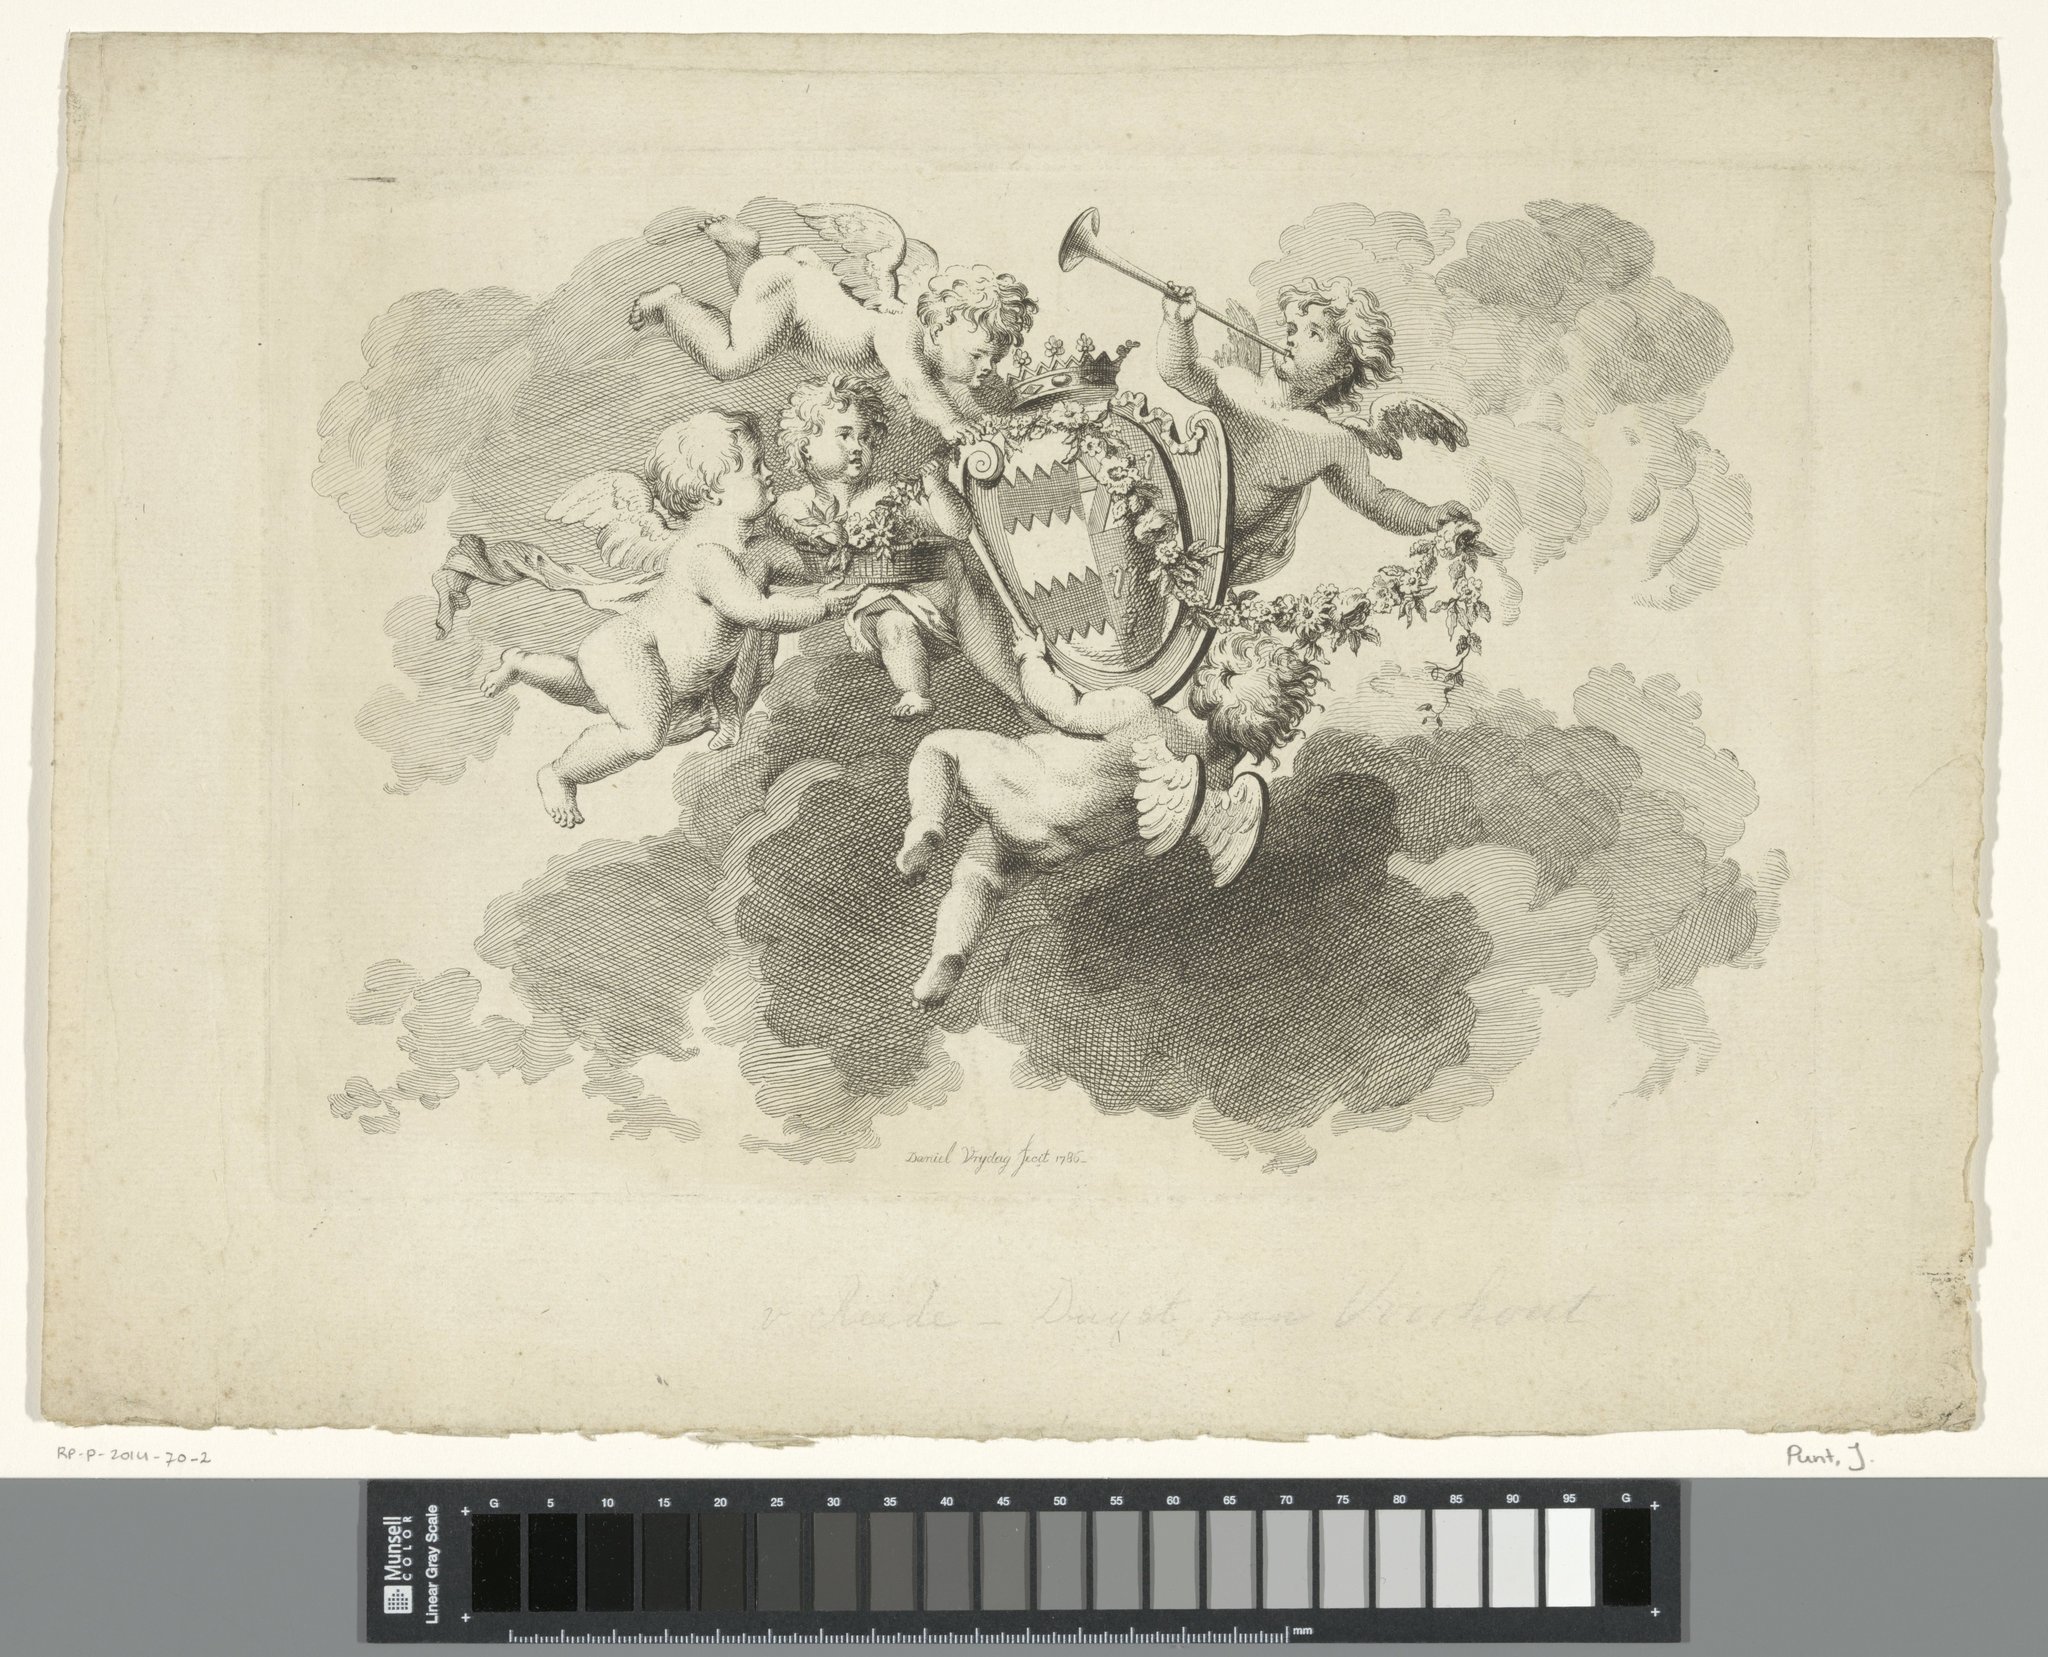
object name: print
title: Vijf putti in de wolken met een wapenschild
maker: daniël vrijdag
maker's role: draughtsman, print maker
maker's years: 1765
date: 1786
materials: paper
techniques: engraving, etching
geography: netherlands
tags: cupids: 'amores', 'amoretti', 'putti', armorial bearing, heraldry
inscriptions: collector's mark: Lugt 2228, collector's mark: Lugt 2760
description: Vijf putti in de wolken met het wapenschild van de familie Van Reede-Duyst van Voorhout.